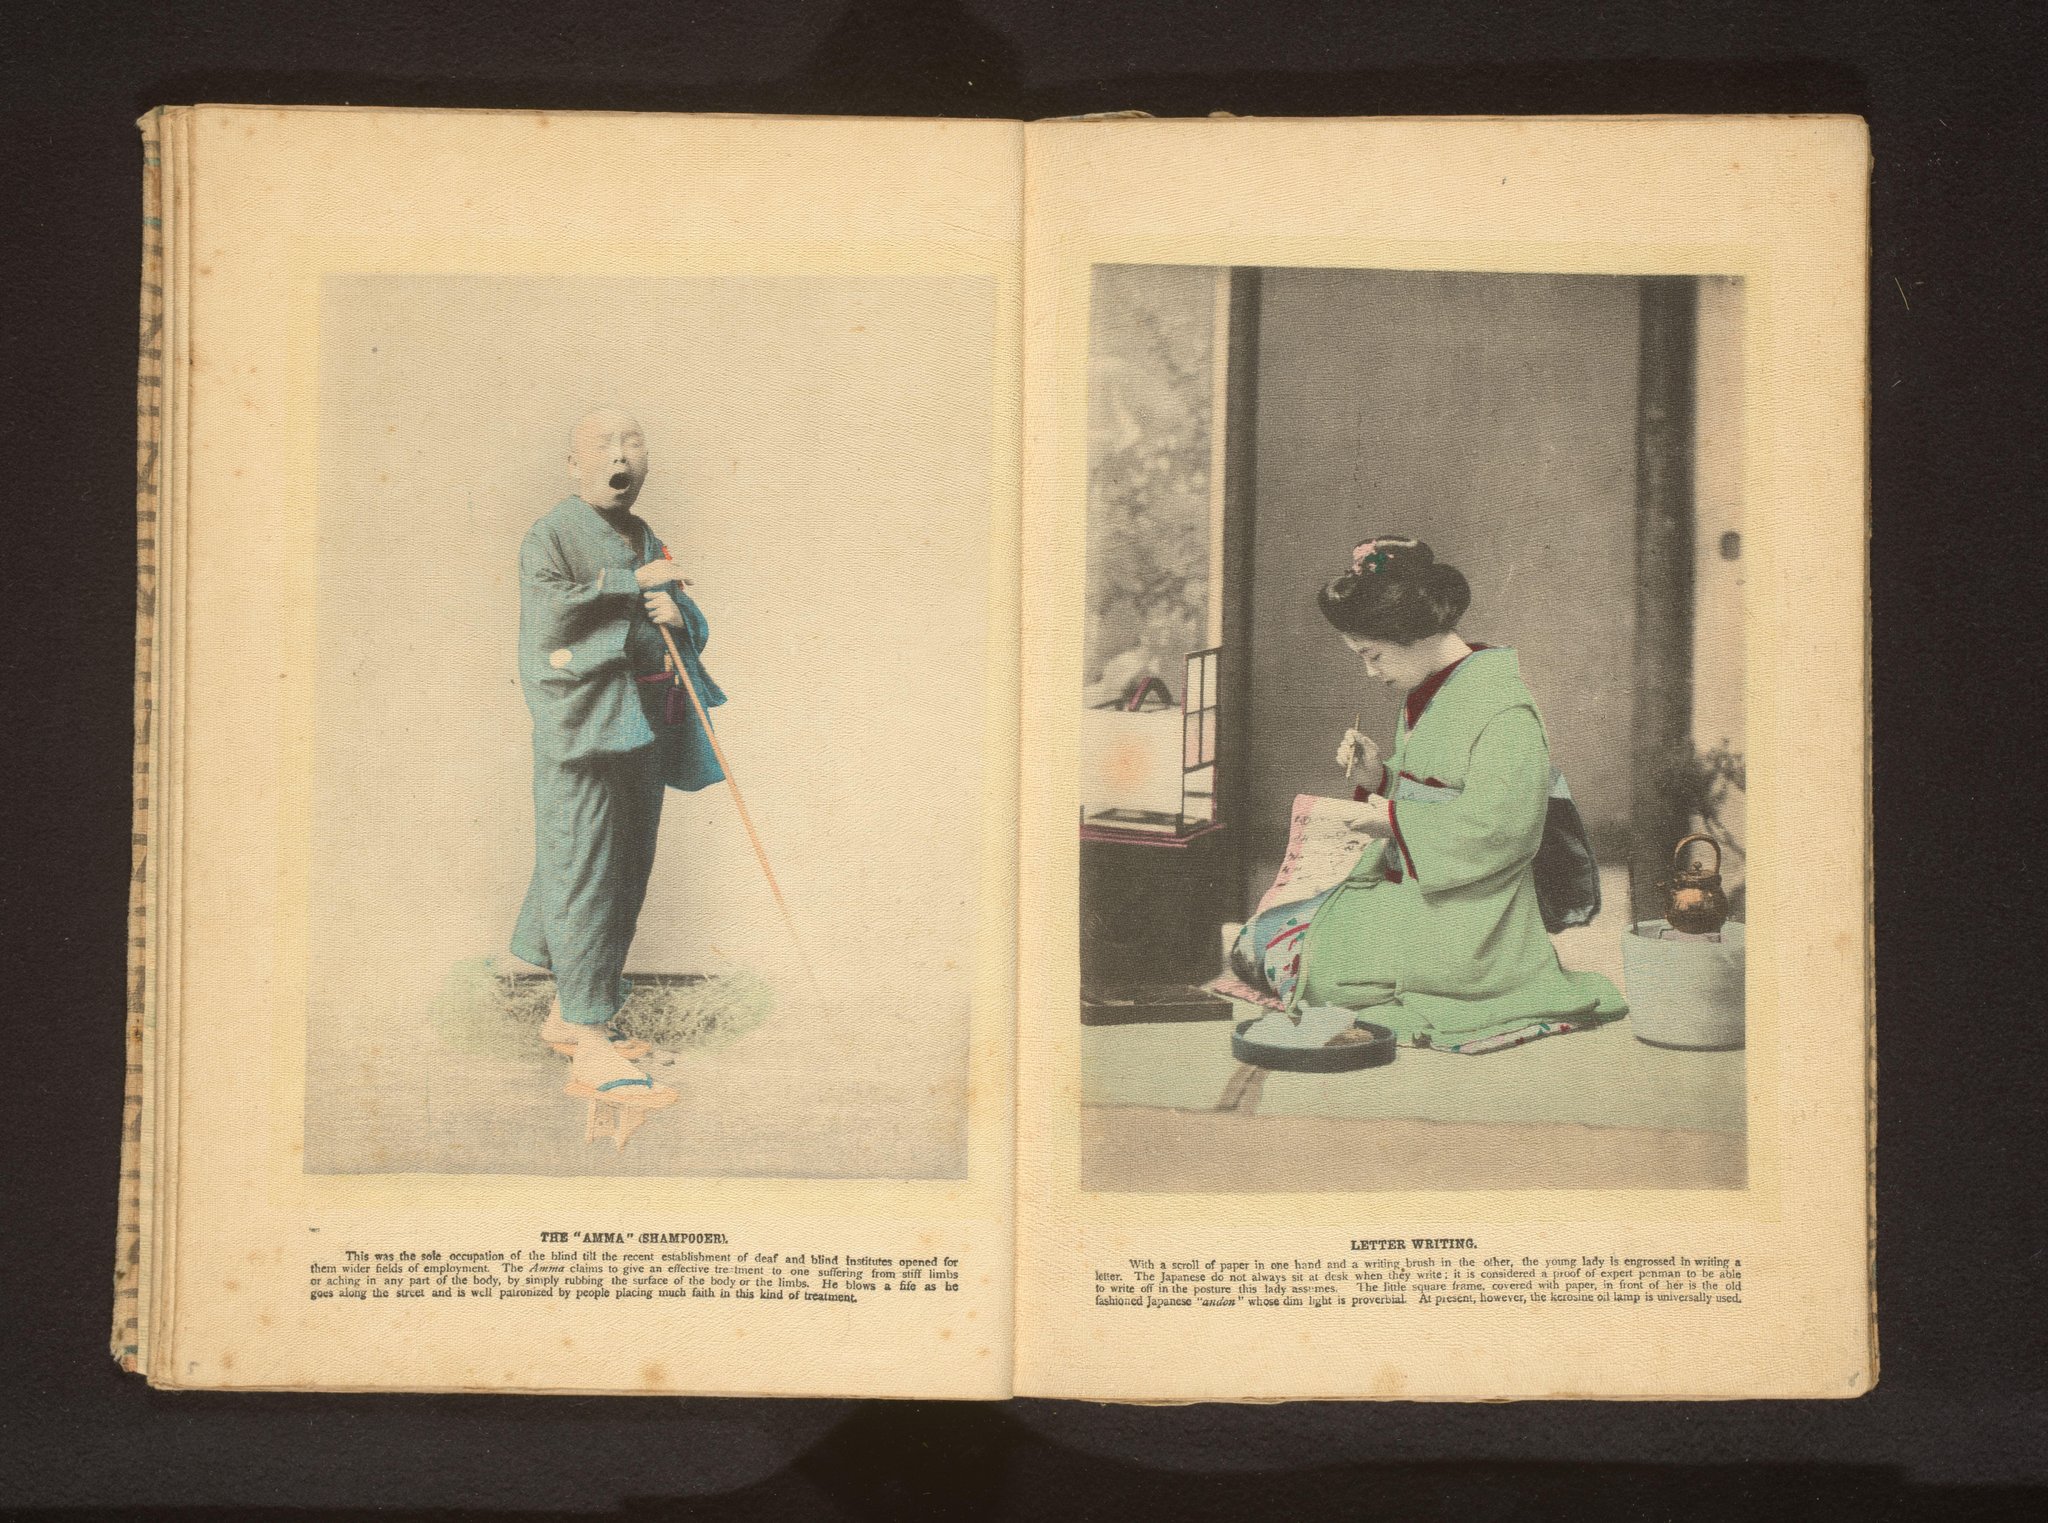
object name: photomechanical print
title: Letter writing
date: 1886-1896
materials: paper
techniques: photograph, hand coloring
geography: japan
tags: handwriting, writing as activity, adult woman, interior ~ representation of a building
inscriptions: inscription: ‘With a scroll of paper (...) oil lamp is universally used.’